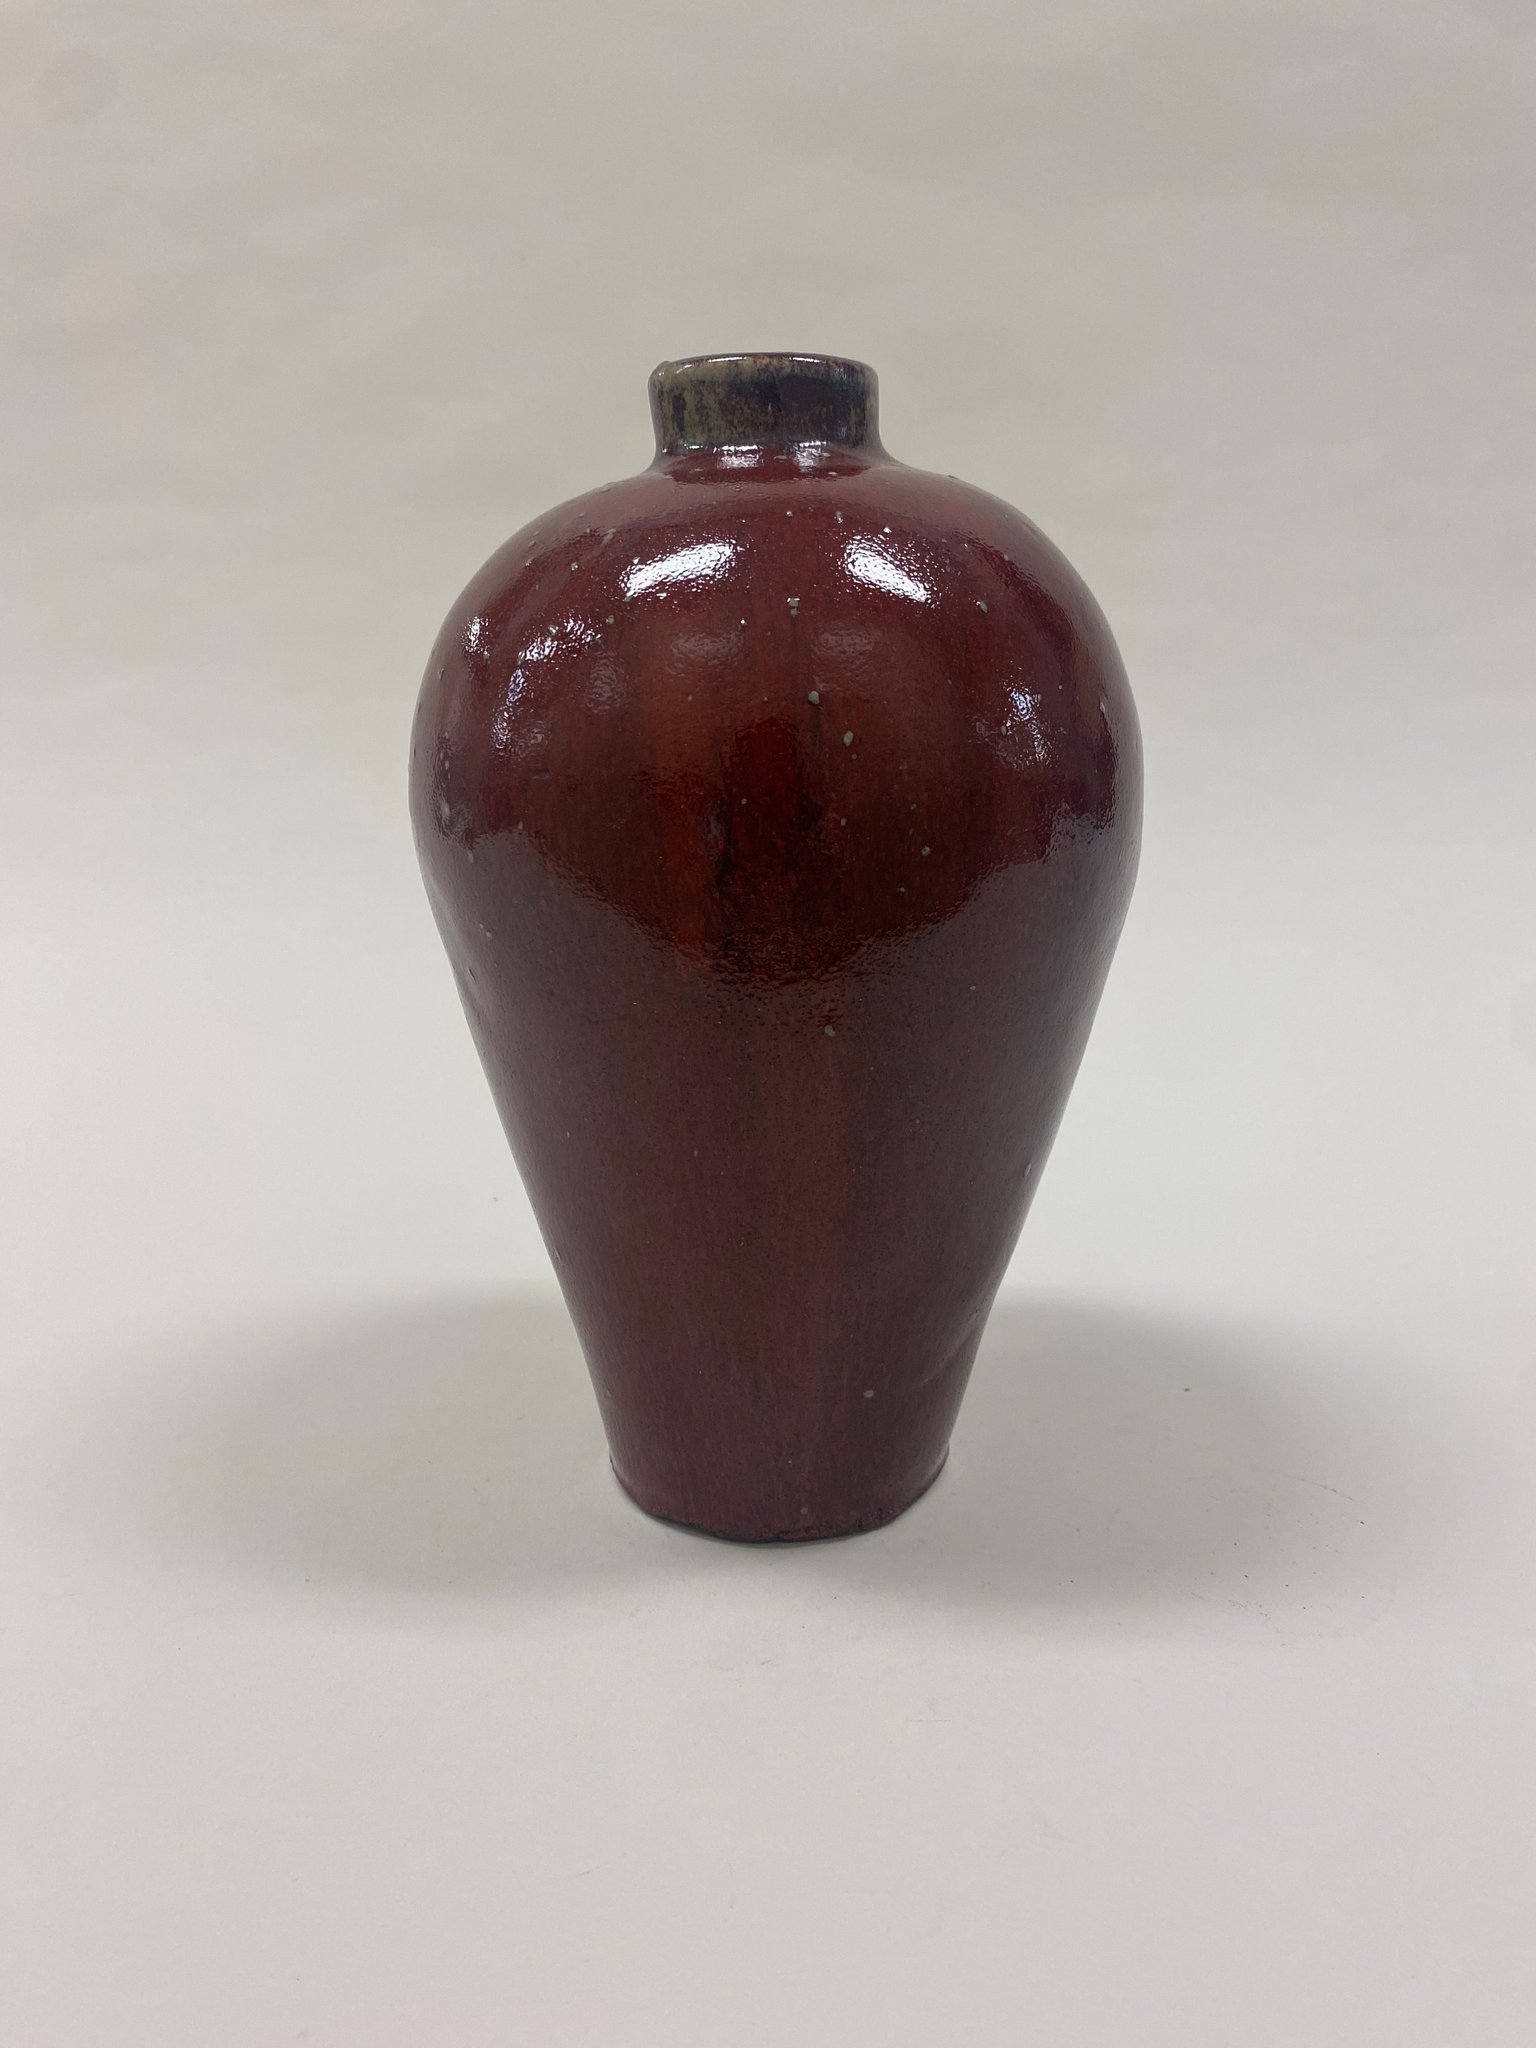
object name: vase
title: Meiping vase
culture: chinese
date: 1801-1900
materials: glaze, stoneware